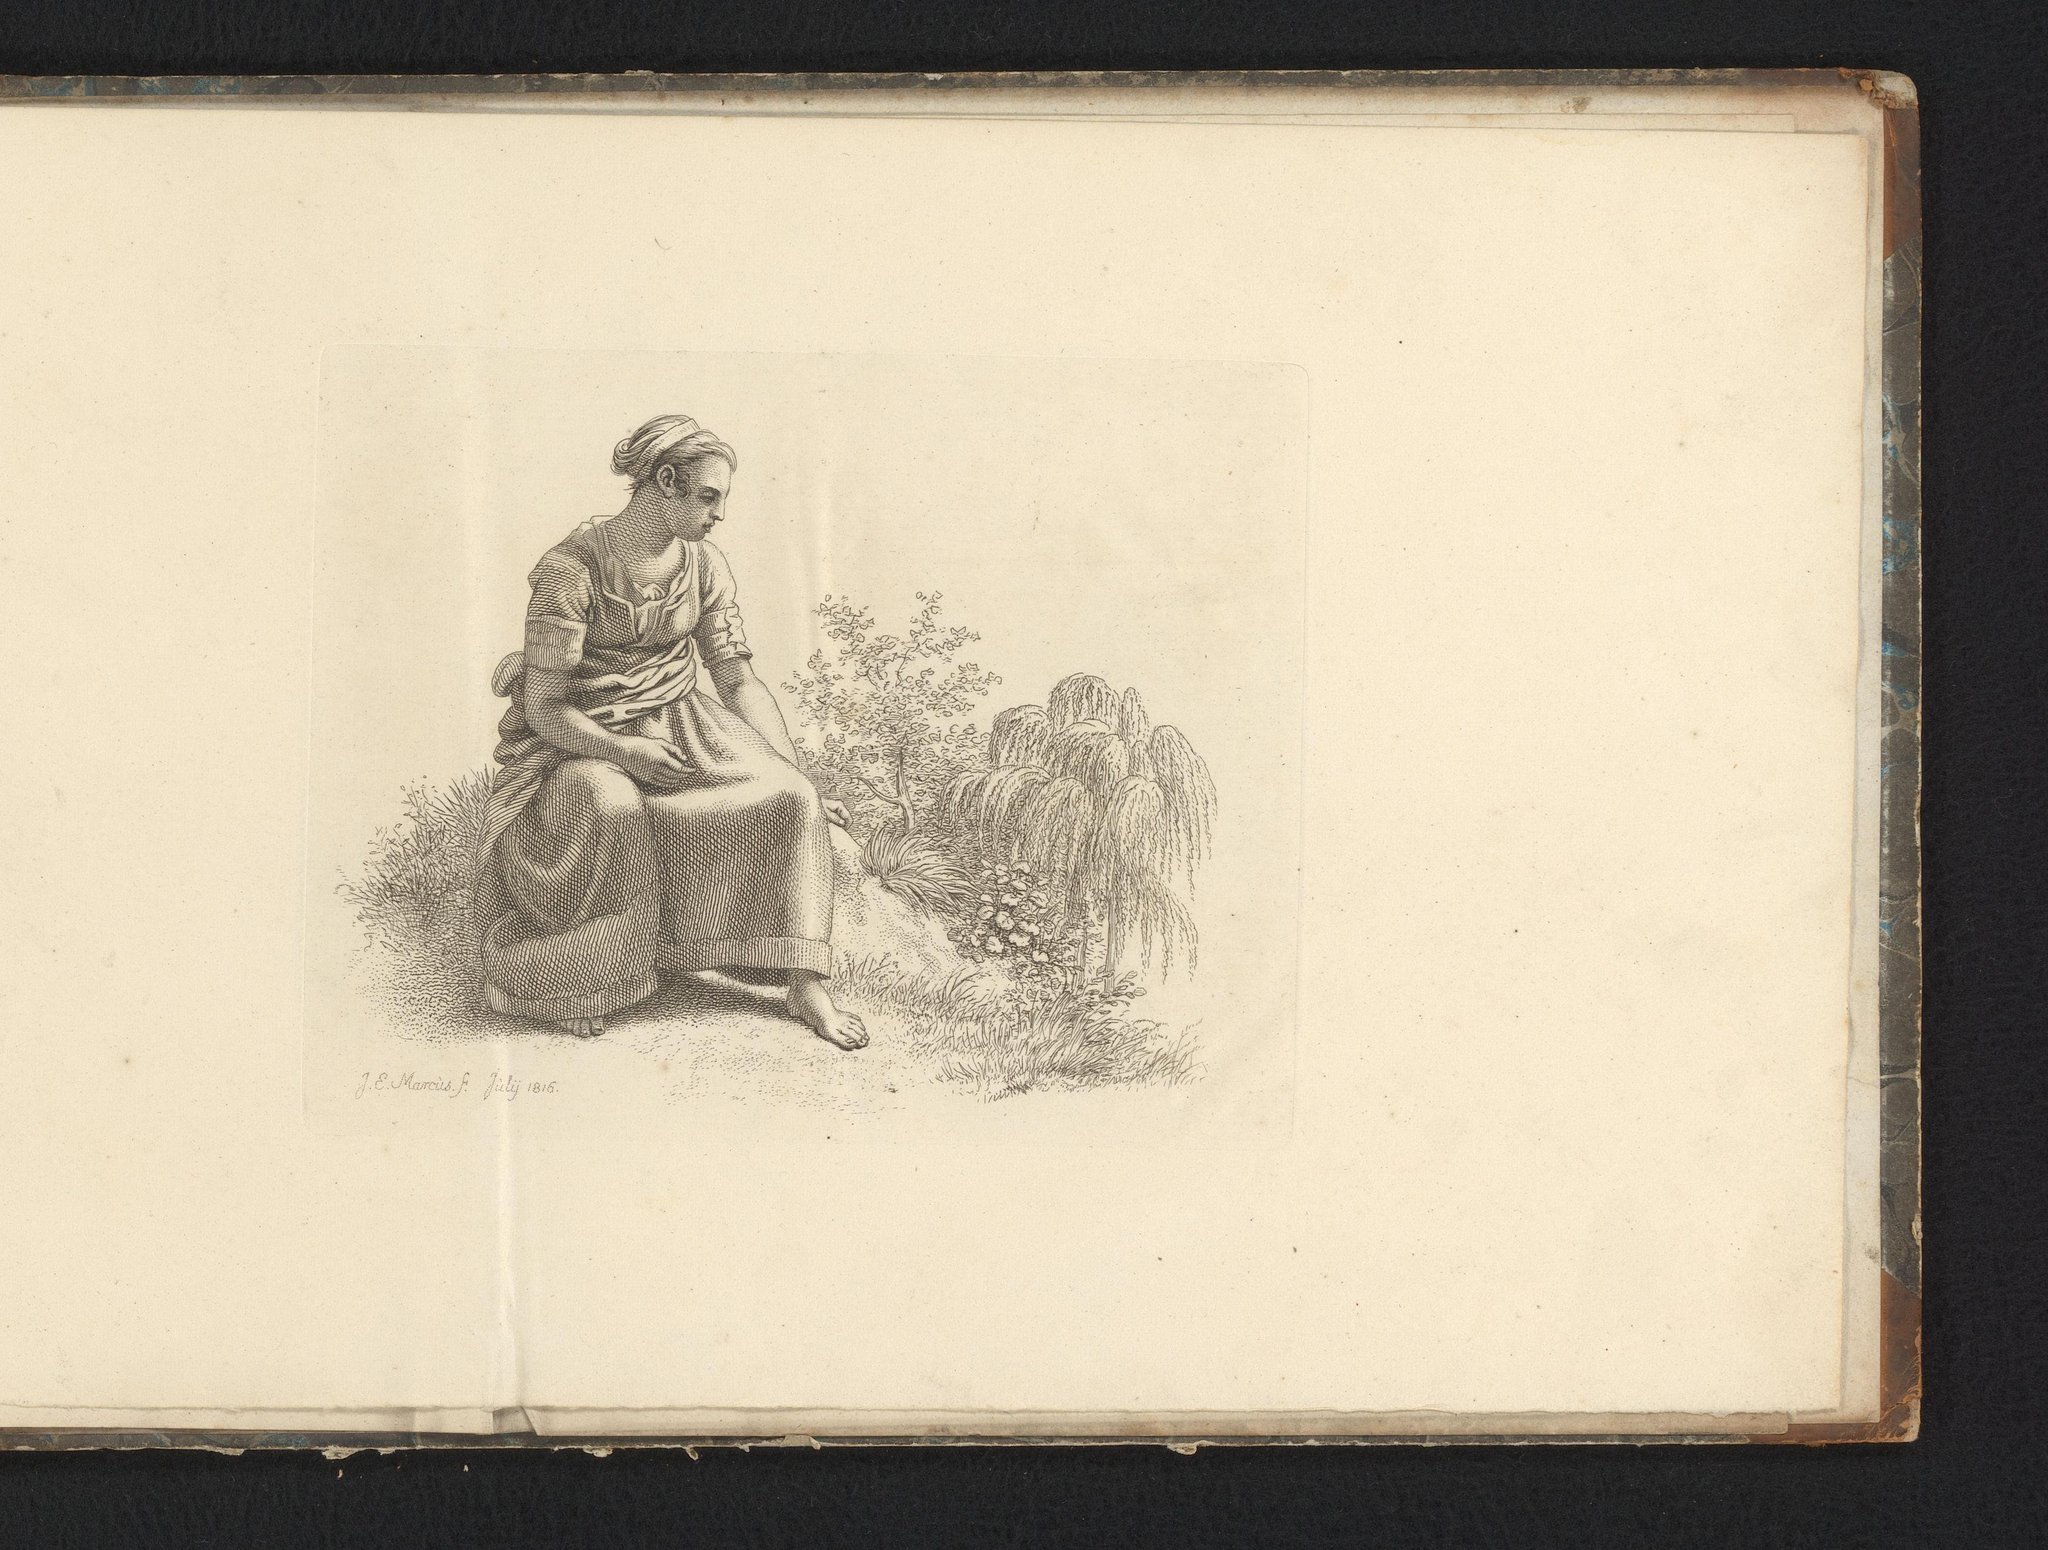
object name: album leaf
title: Studiebeelden en fragmenten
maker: jacob ernst marcus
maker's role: draughtsman, print maker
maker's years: 1774-1826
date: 1807-1816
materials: paper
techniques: etching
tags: adult woman, landscapes in the temperate zone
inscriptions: date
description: Deze prent maakt deel uit van een album.